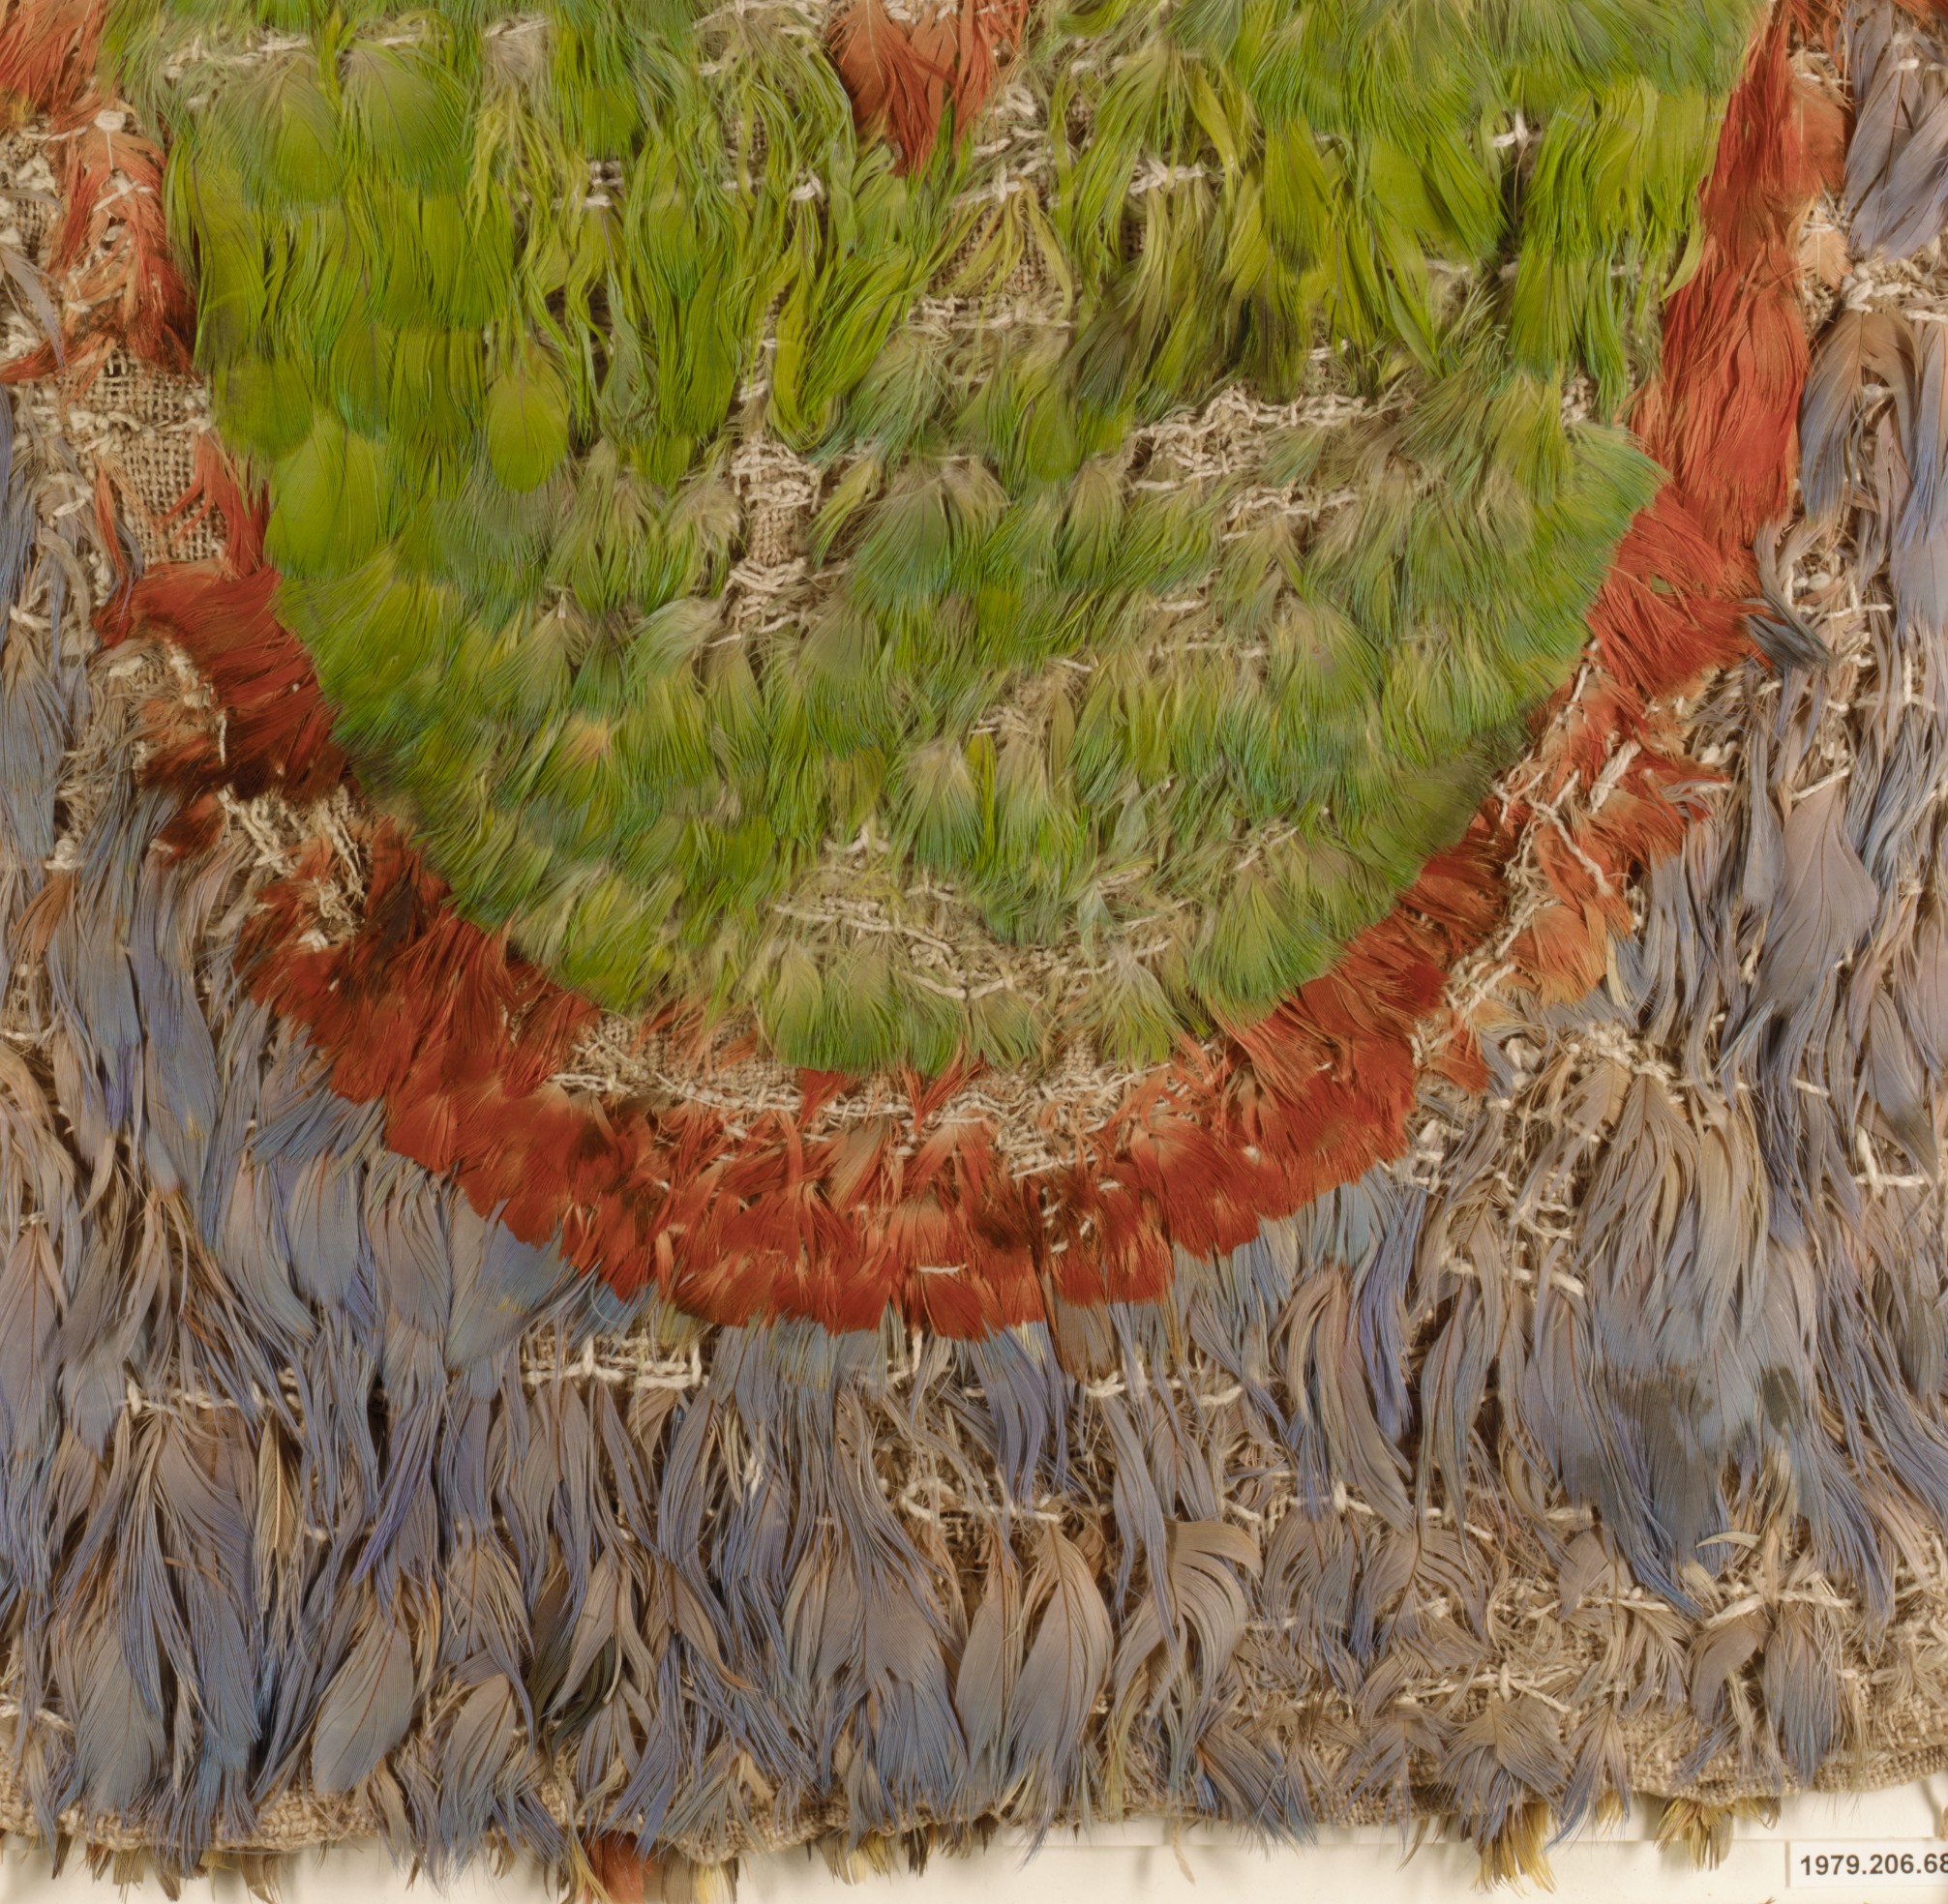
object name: miniature tunic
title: MiniatureTunic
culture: ica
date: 1101-1300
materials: cotton, feather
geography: peru